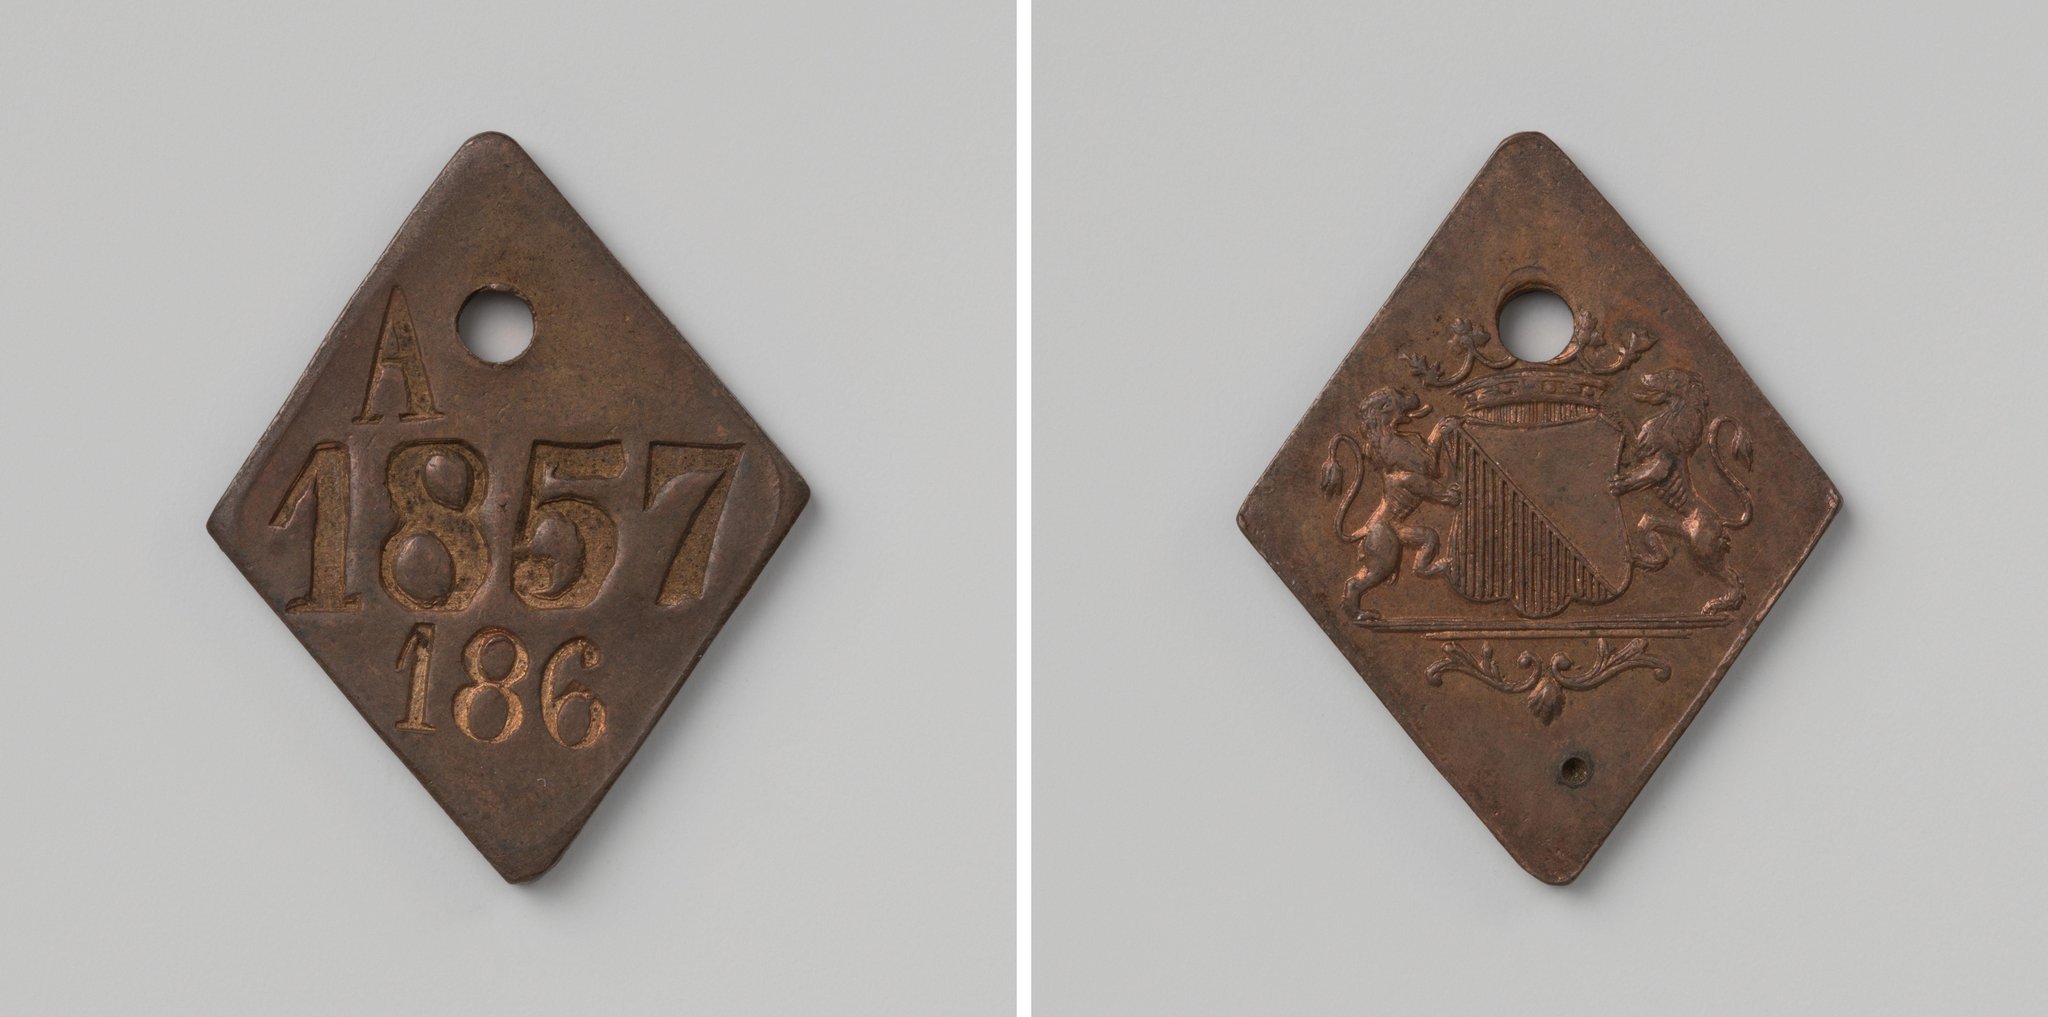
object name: hondenbelastingloodje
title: Stad Utrecht, loodje met letter A en no. 186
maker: Anonymous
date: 1857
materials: copper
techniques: striking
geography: utrecht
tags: utrecht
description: ruitvormig loodje met afgeronde hoeken en gat erin. Voorzijde: letter A boven jaartal en cijfer 186. Keerzijde: gekroond wapenschild, geflankeerd door twee leeuwen